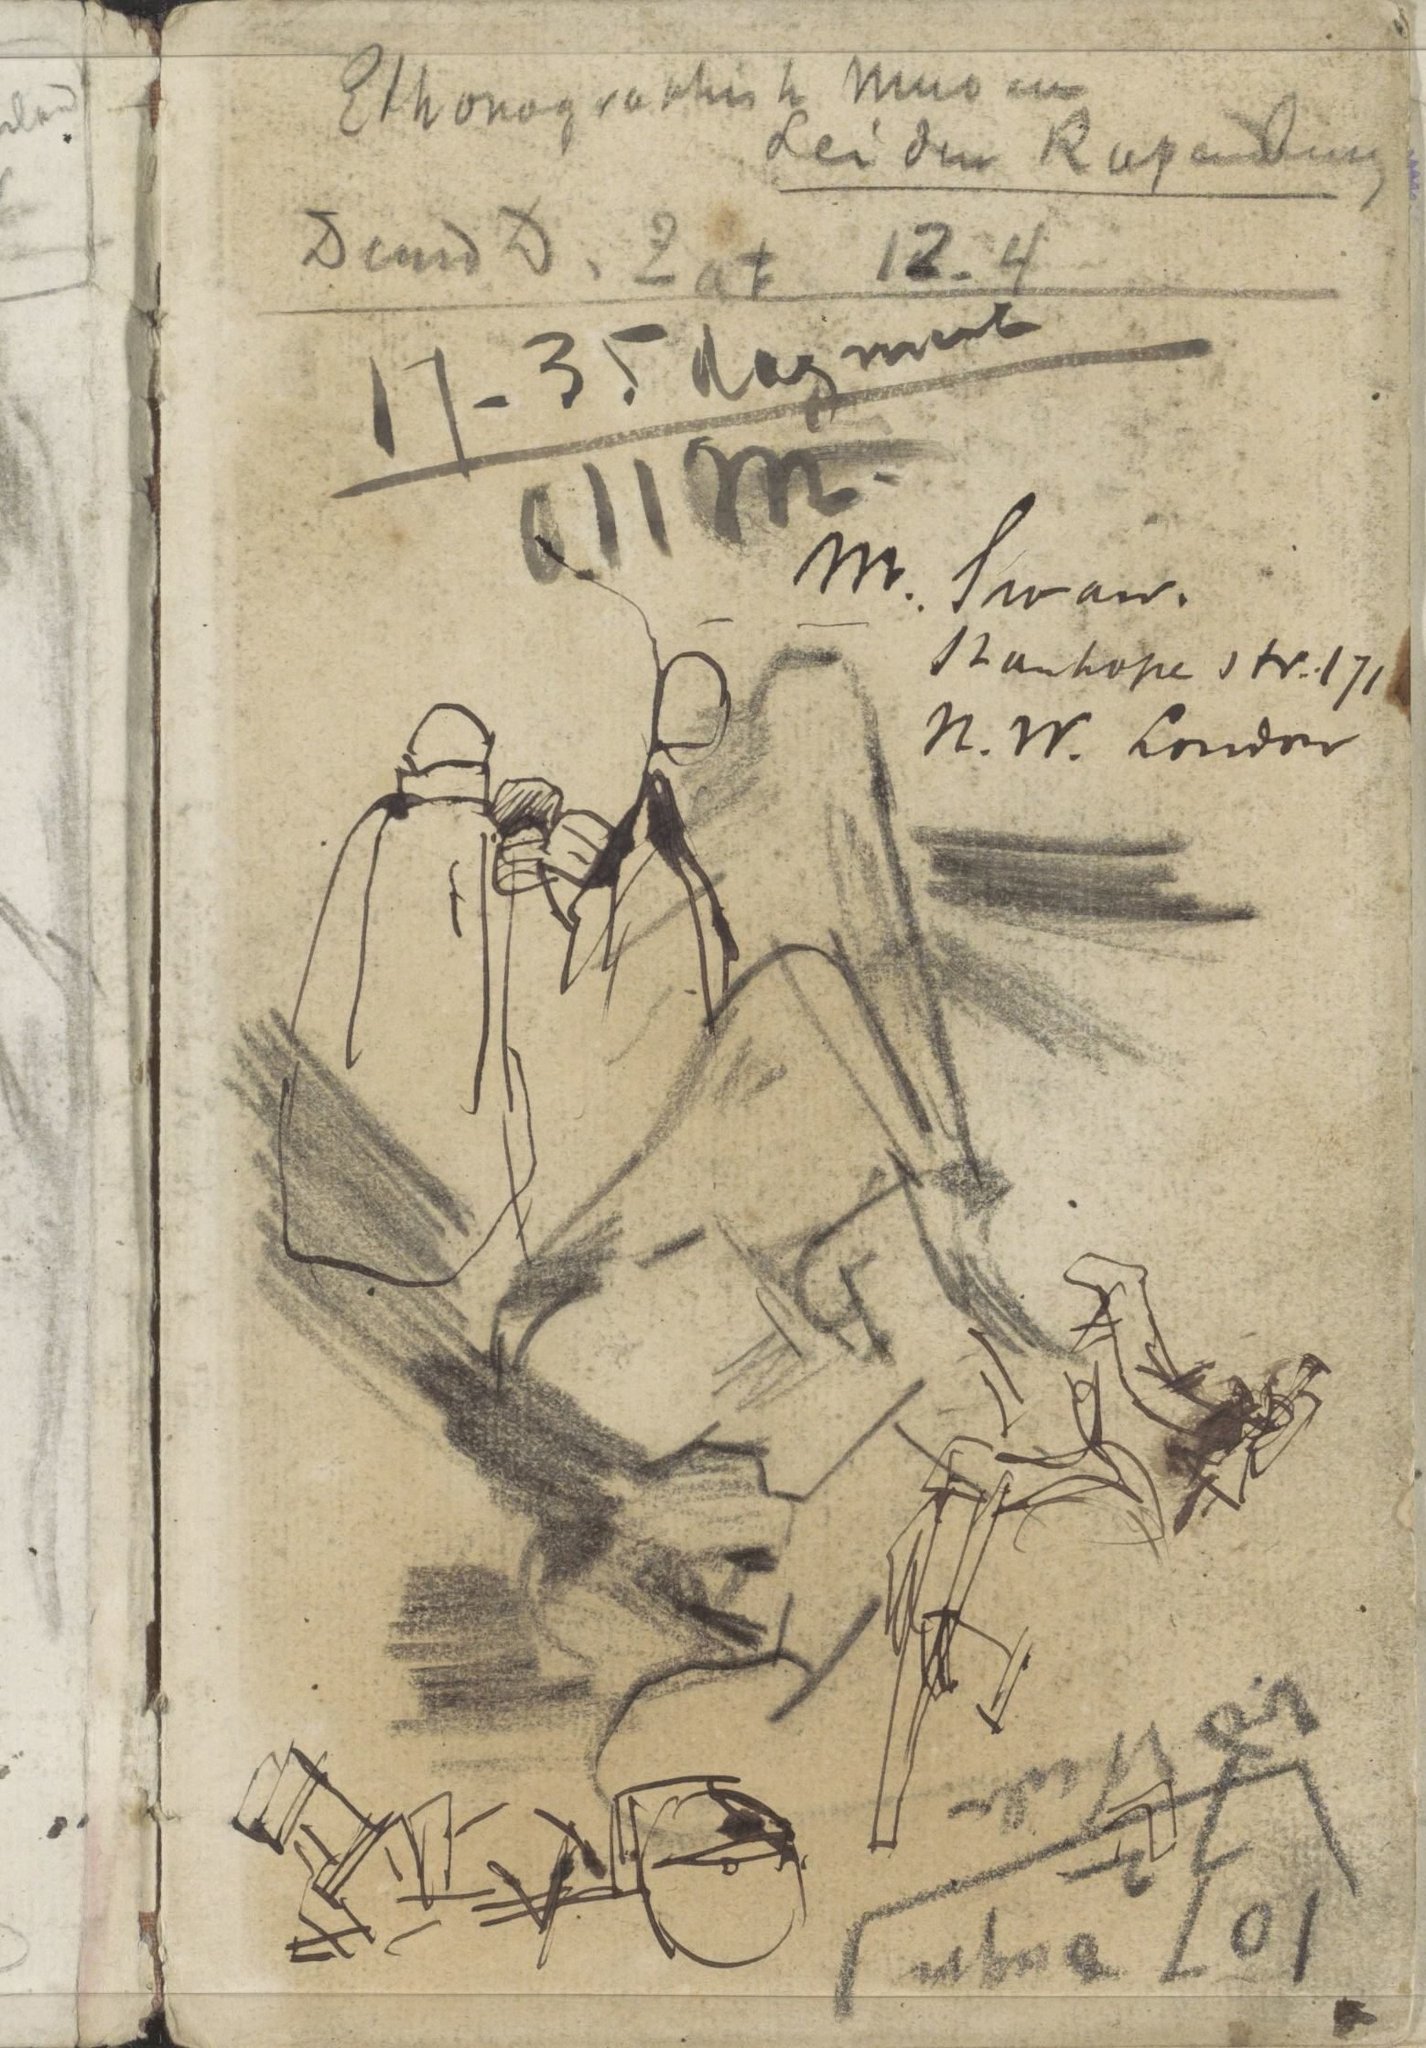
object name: sketchbook leaf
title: Figuurstudies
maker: george hendrik breitner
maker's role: draughtsman, painter, print maker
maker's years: 1857-1923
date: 1883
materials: chalk, ink, paper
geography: the hague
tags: adult man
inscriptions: annotation: ‘Ethonogra[...] Museum/ Leiden Rapenburg/ Dinsd D. Zat 12.4/ [...]/ M. Sivan/ Stanhope Str 171/ N.W. London/ [...]’